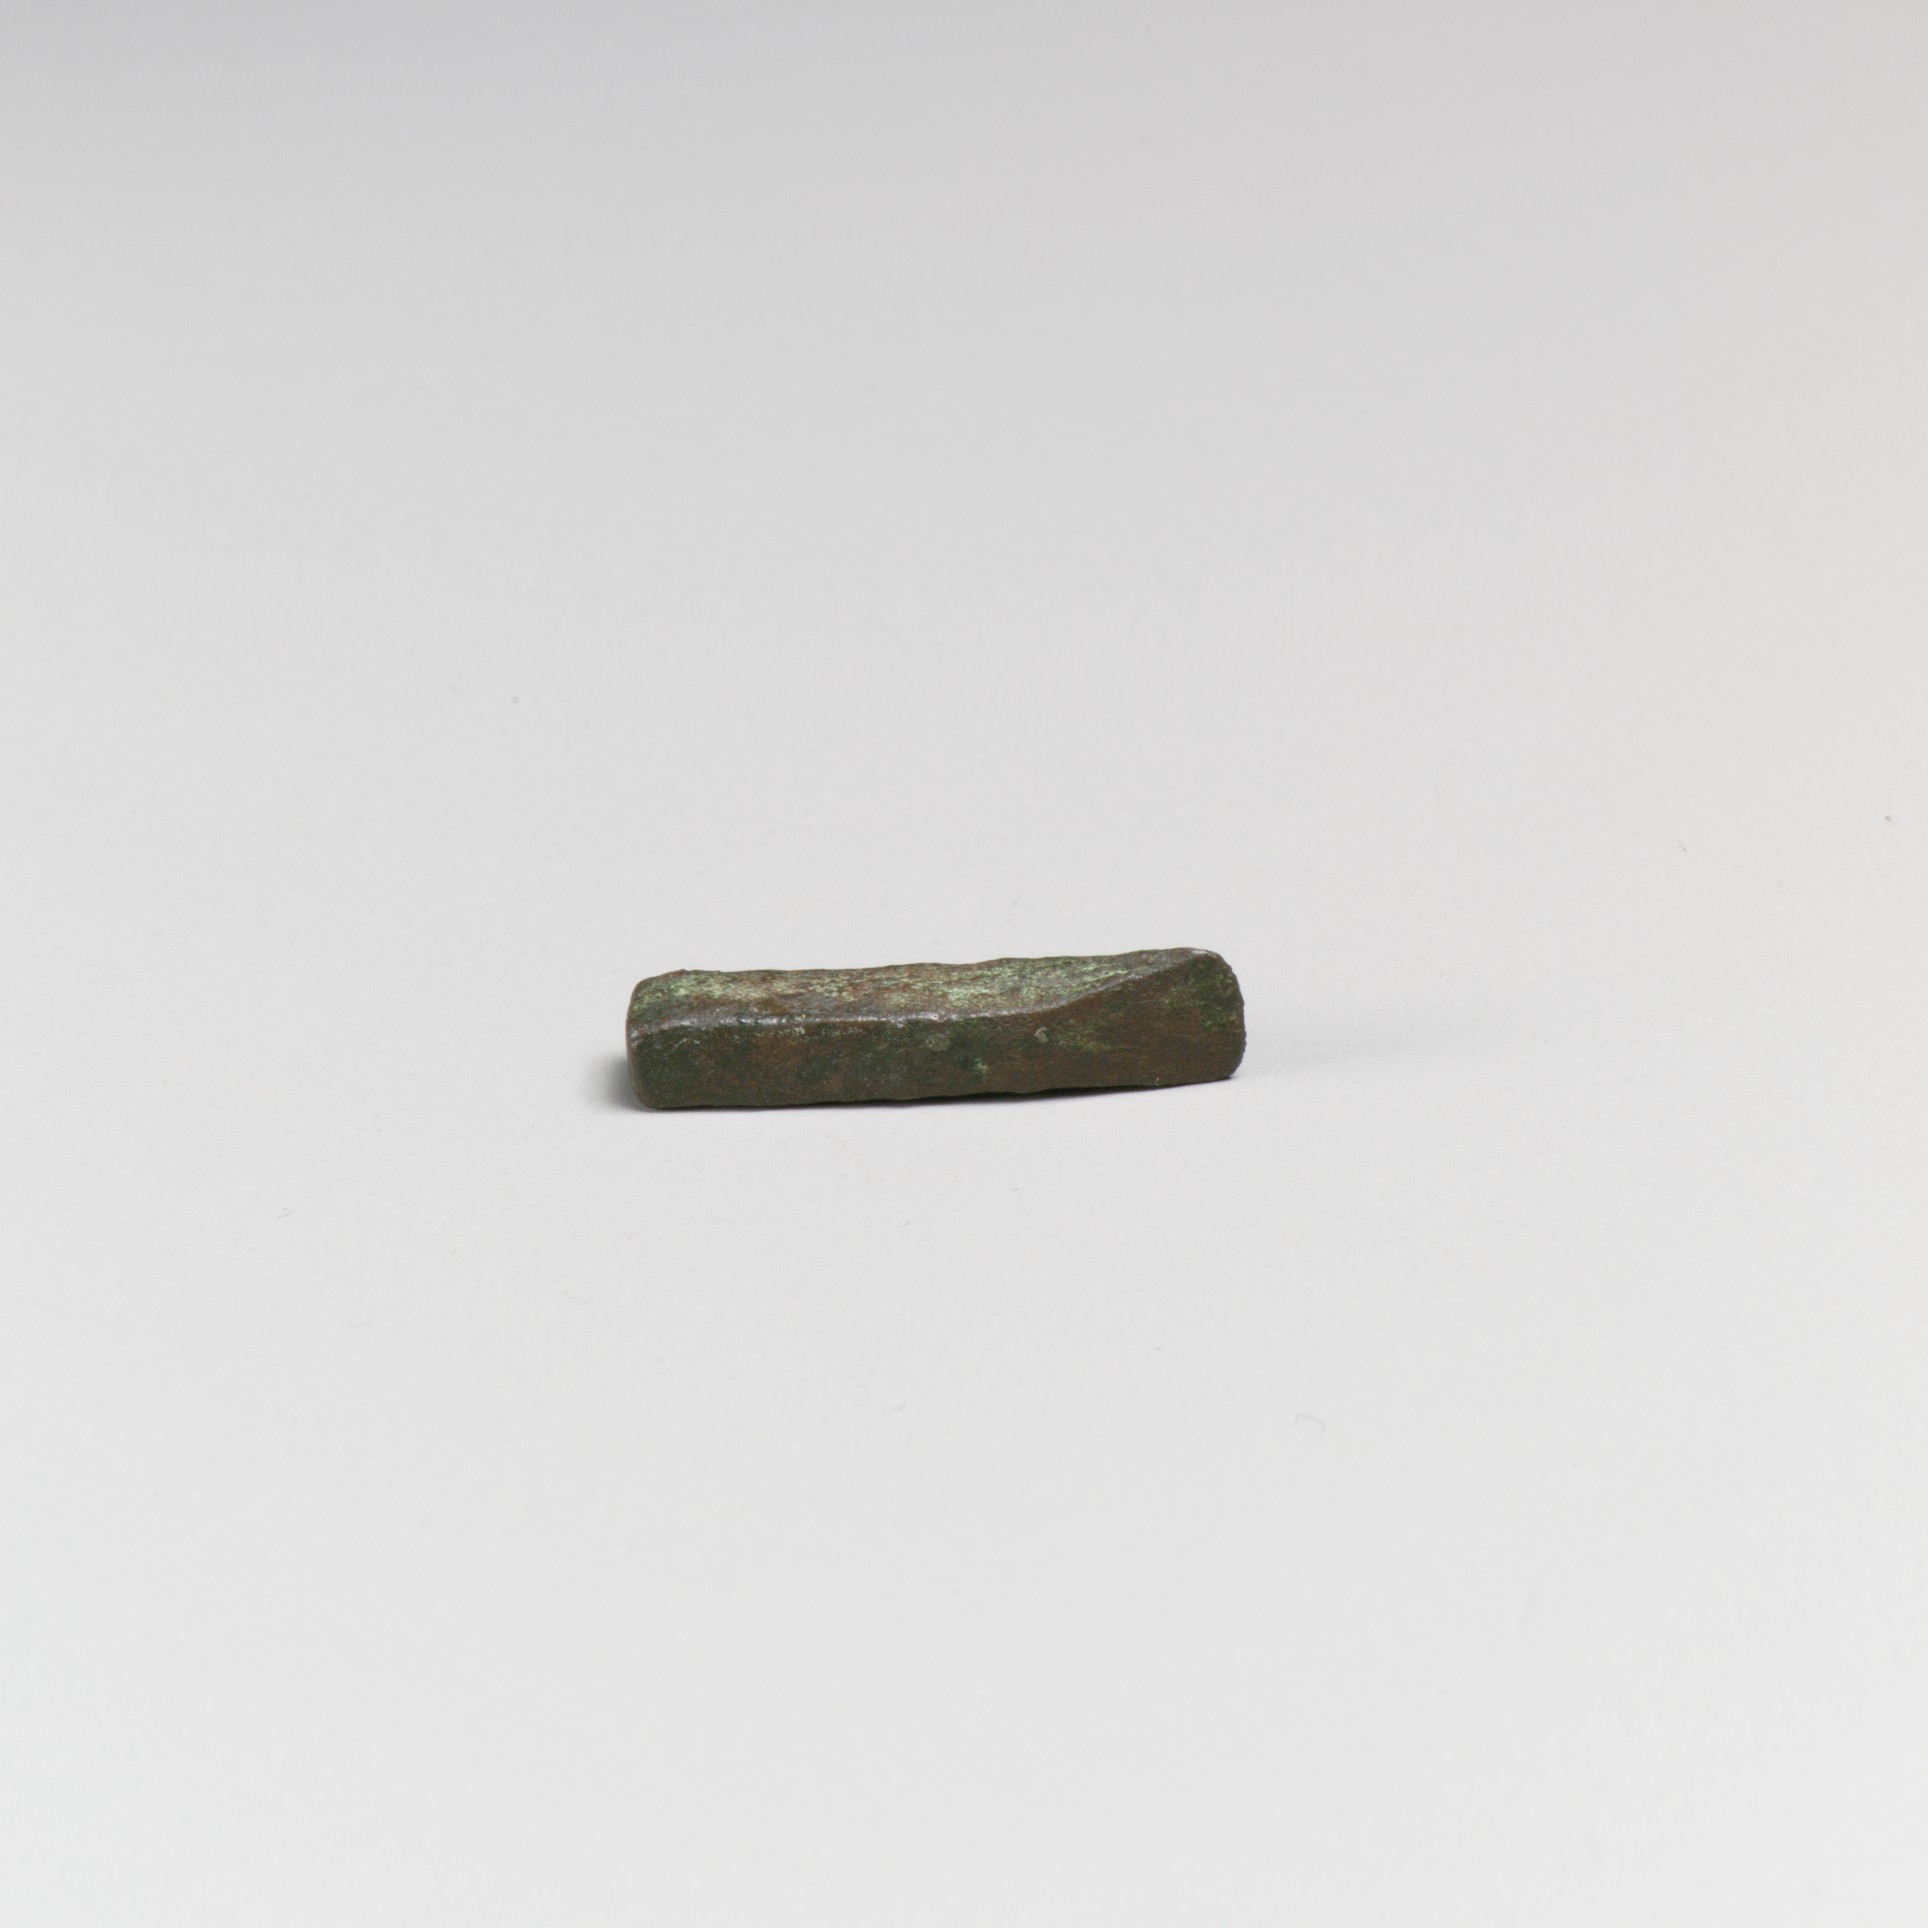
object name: chisel, votive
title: Small bronze chisel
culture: minoan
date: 2000-1001 BCE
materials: bronze